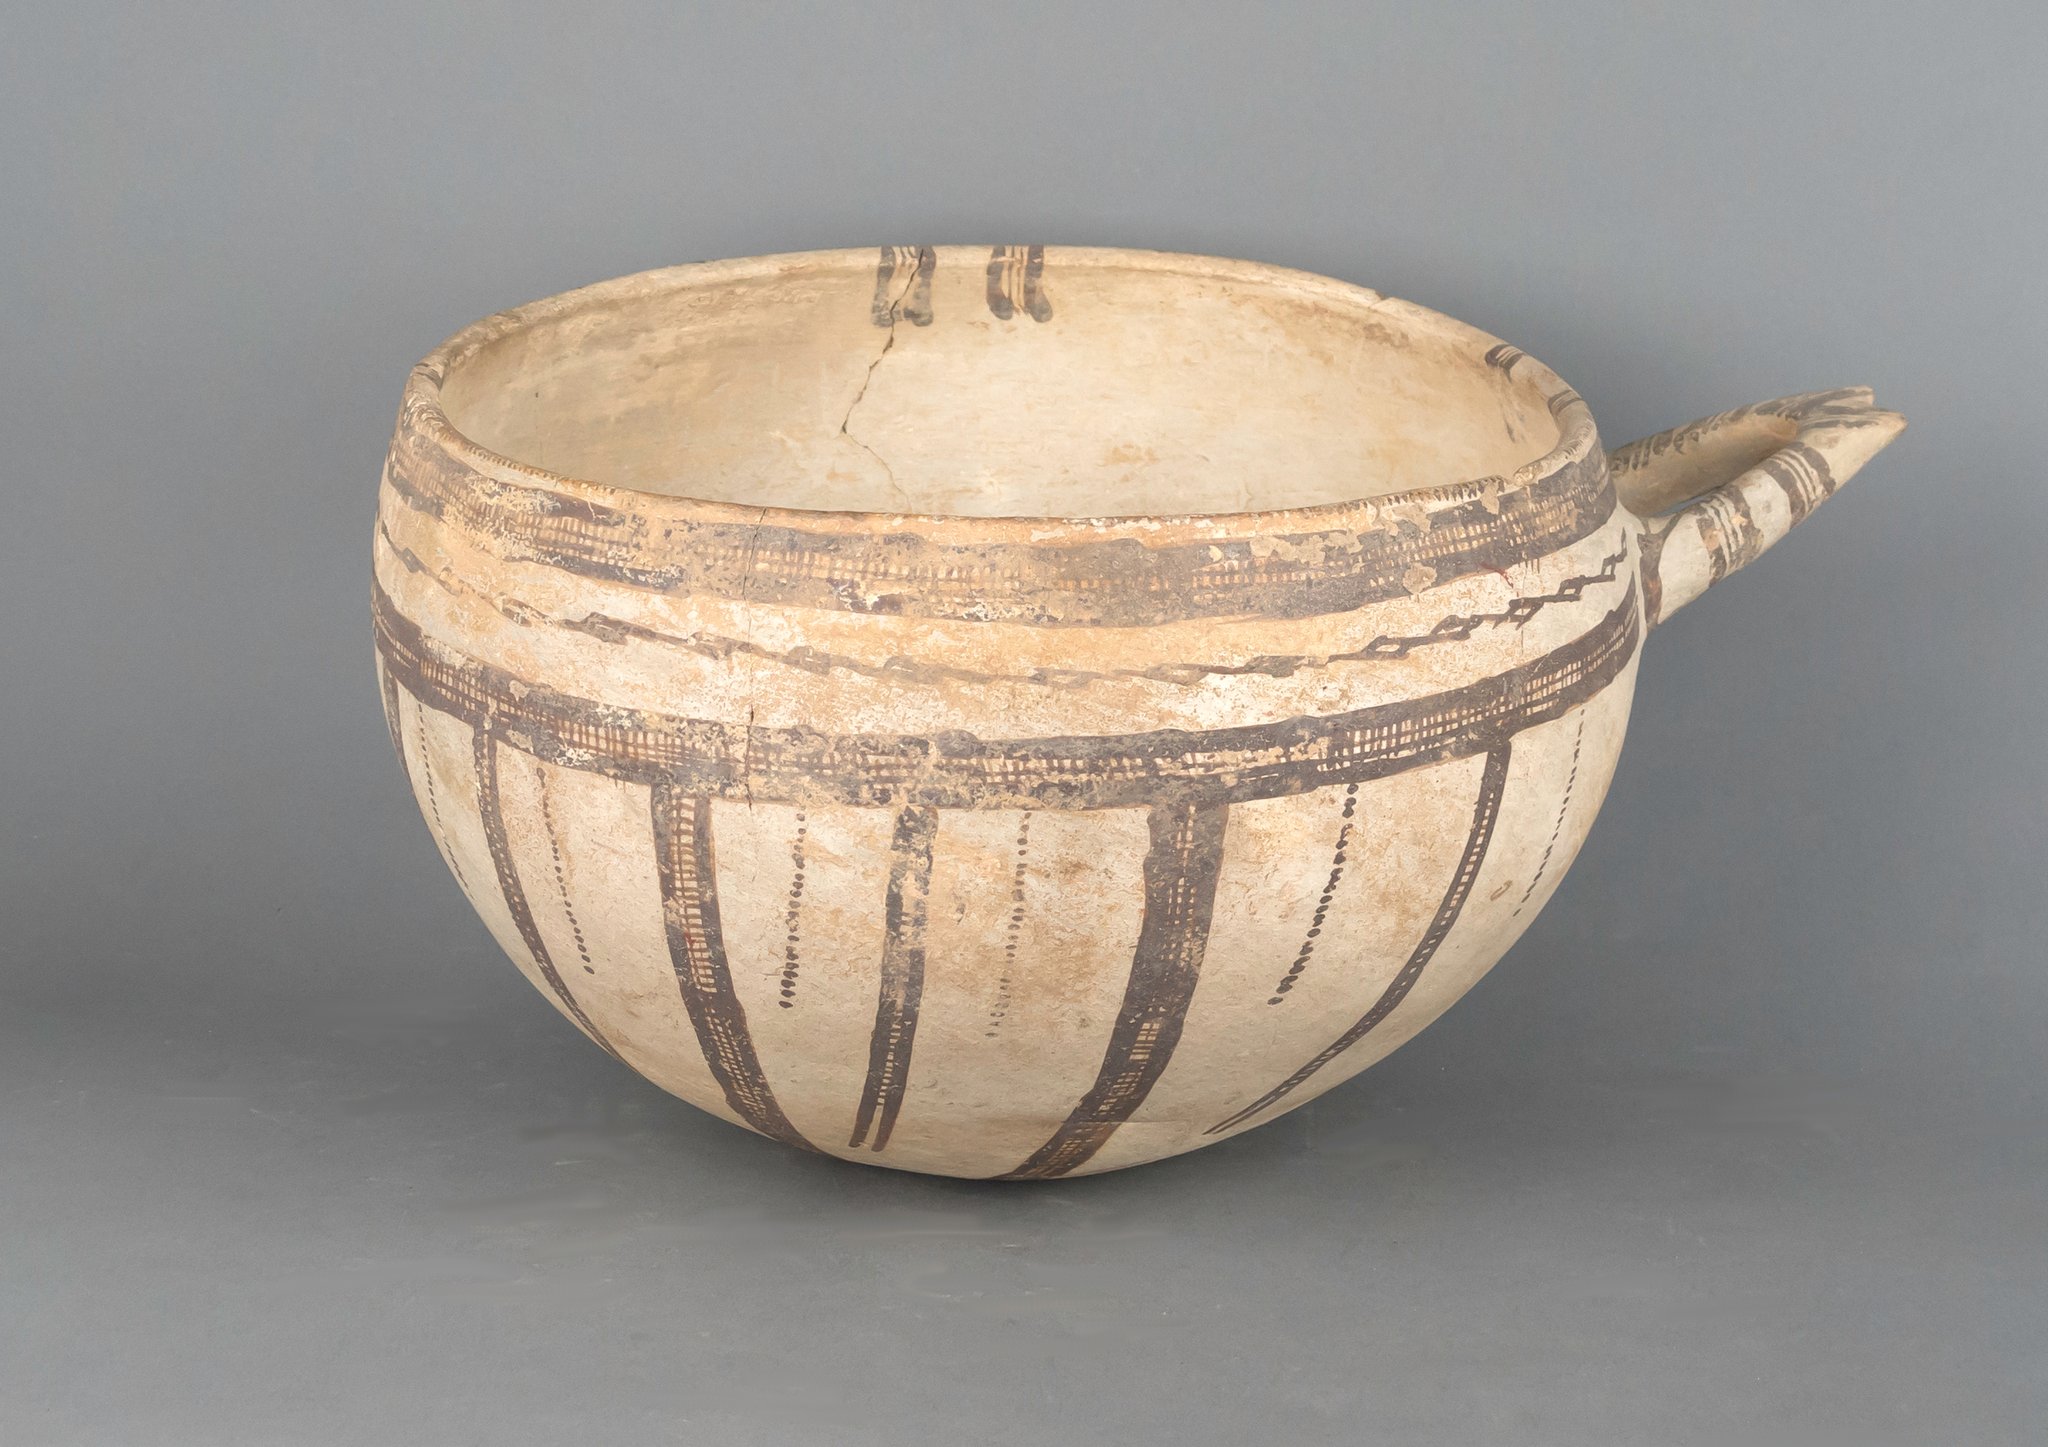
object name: bowl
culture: cypriot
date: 1600-1050 BCE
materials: terracotta